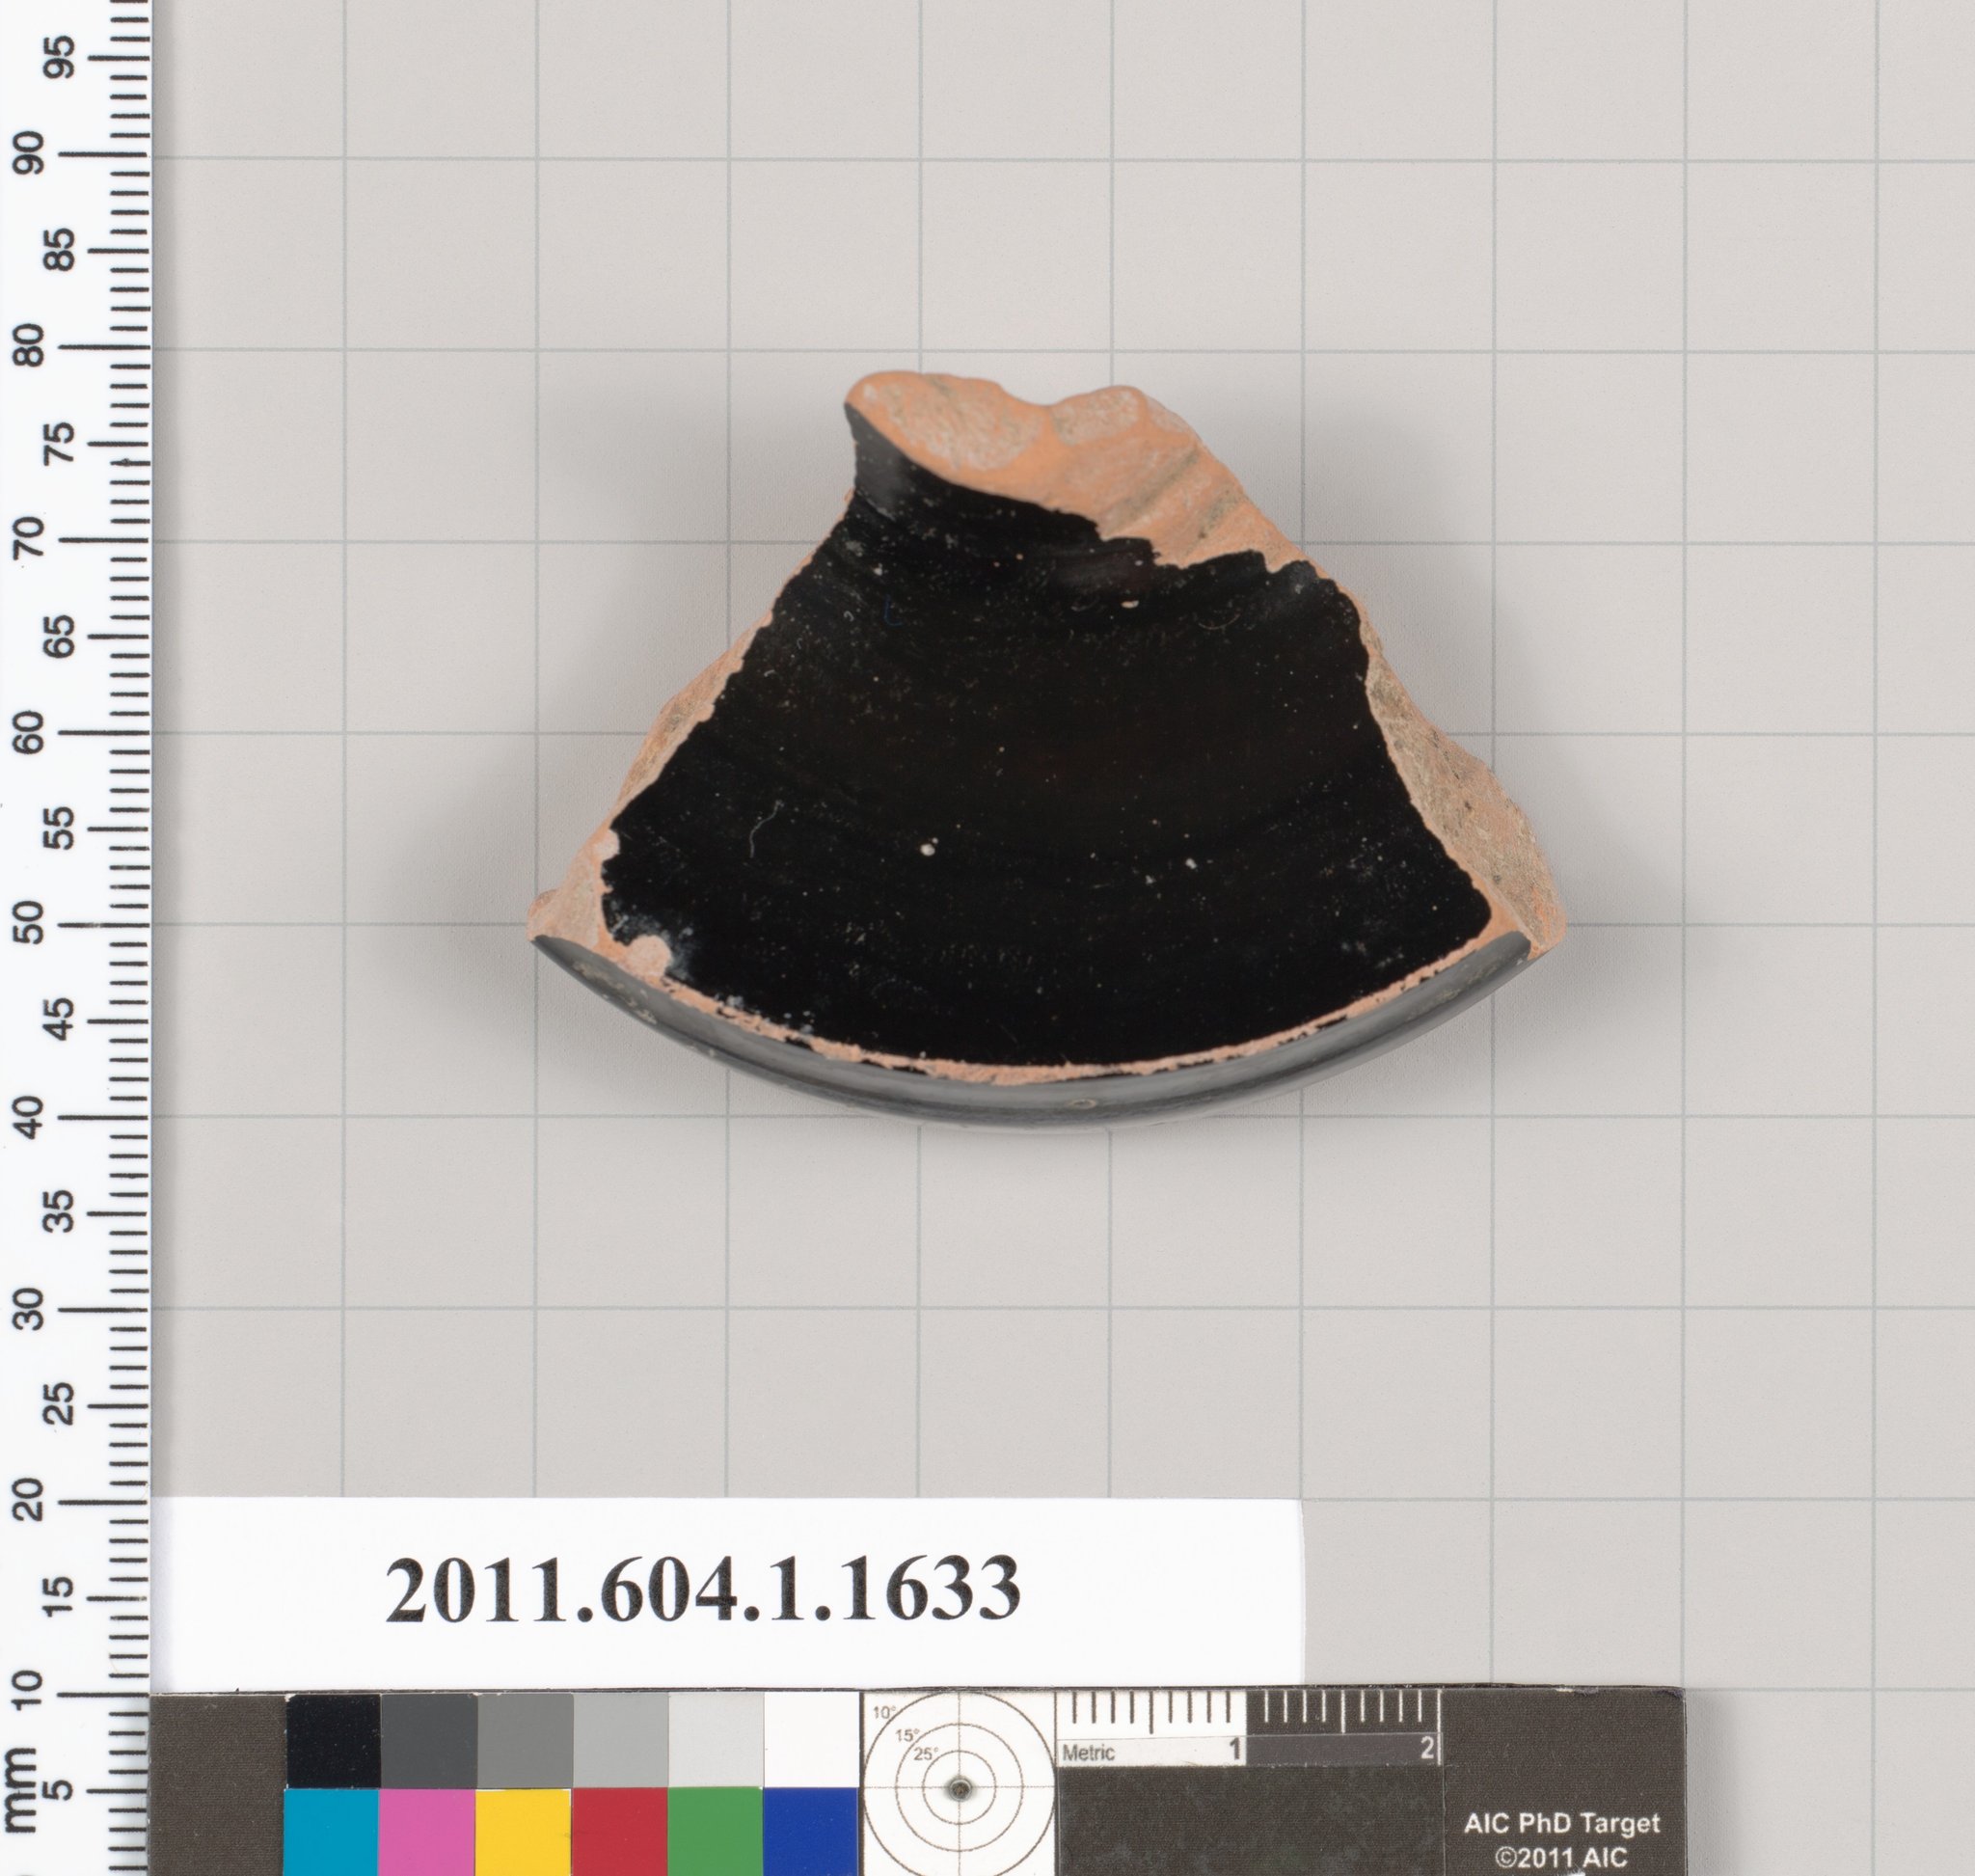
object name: kylix fragment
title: Terracotta fragment of a kylix (drinking cup)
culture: greek, attic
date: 500-401 BCE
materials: terracotta